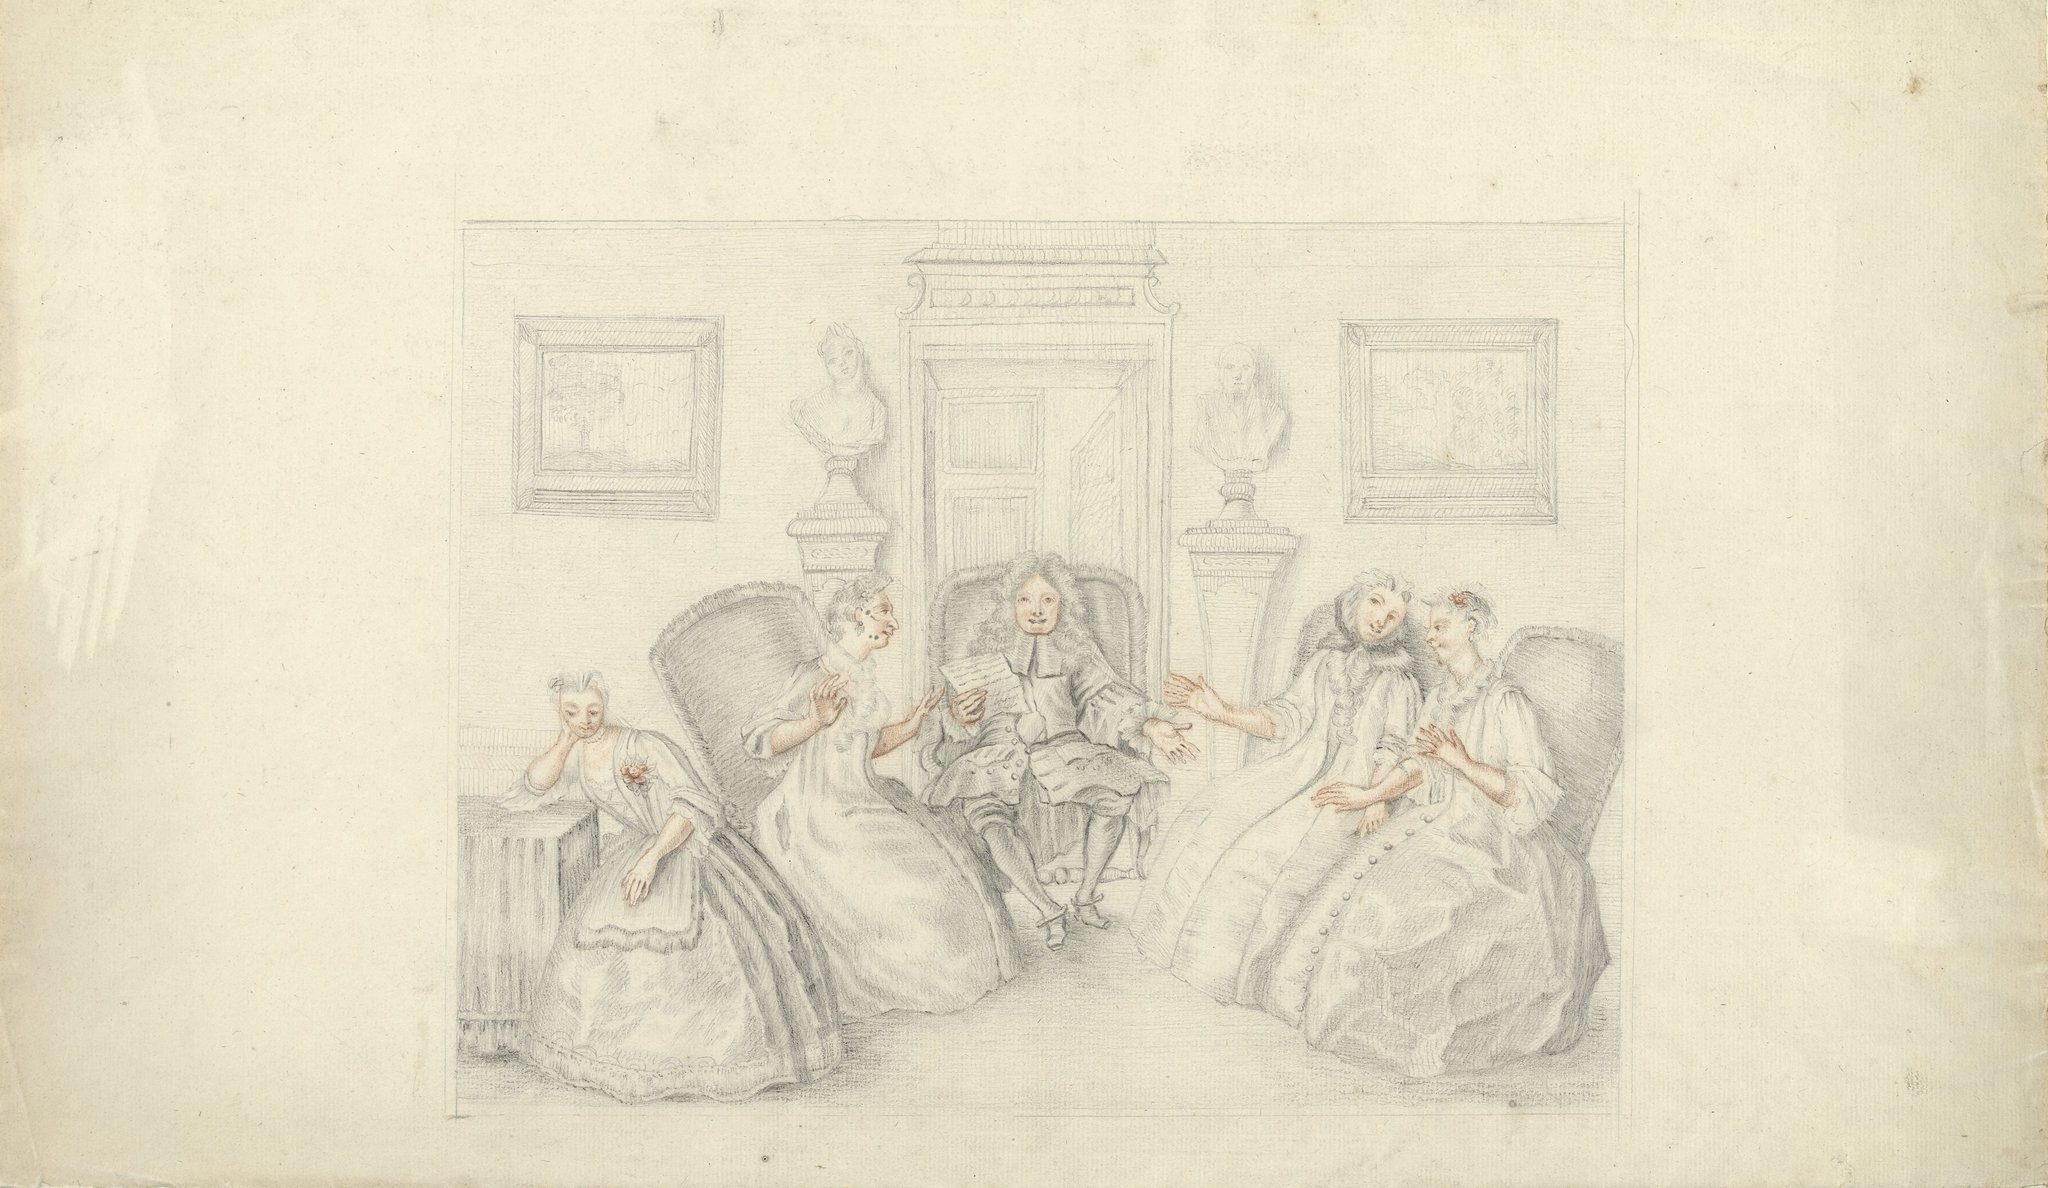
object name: drawing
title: ''Les Femmes savantes'' after Charles Coypel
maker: Anonymous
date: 1726-1800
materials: chalk, paper, pencil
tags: paris, jean baptiste poquelin molière, (moliere) specific works of literature (with author, title), communal rooms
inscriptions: collector's mark, verso, lower centre: Lugt 2165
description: Naar een illustratie voor het toneelstuk door Moliere (bedrijf III, scène 2).